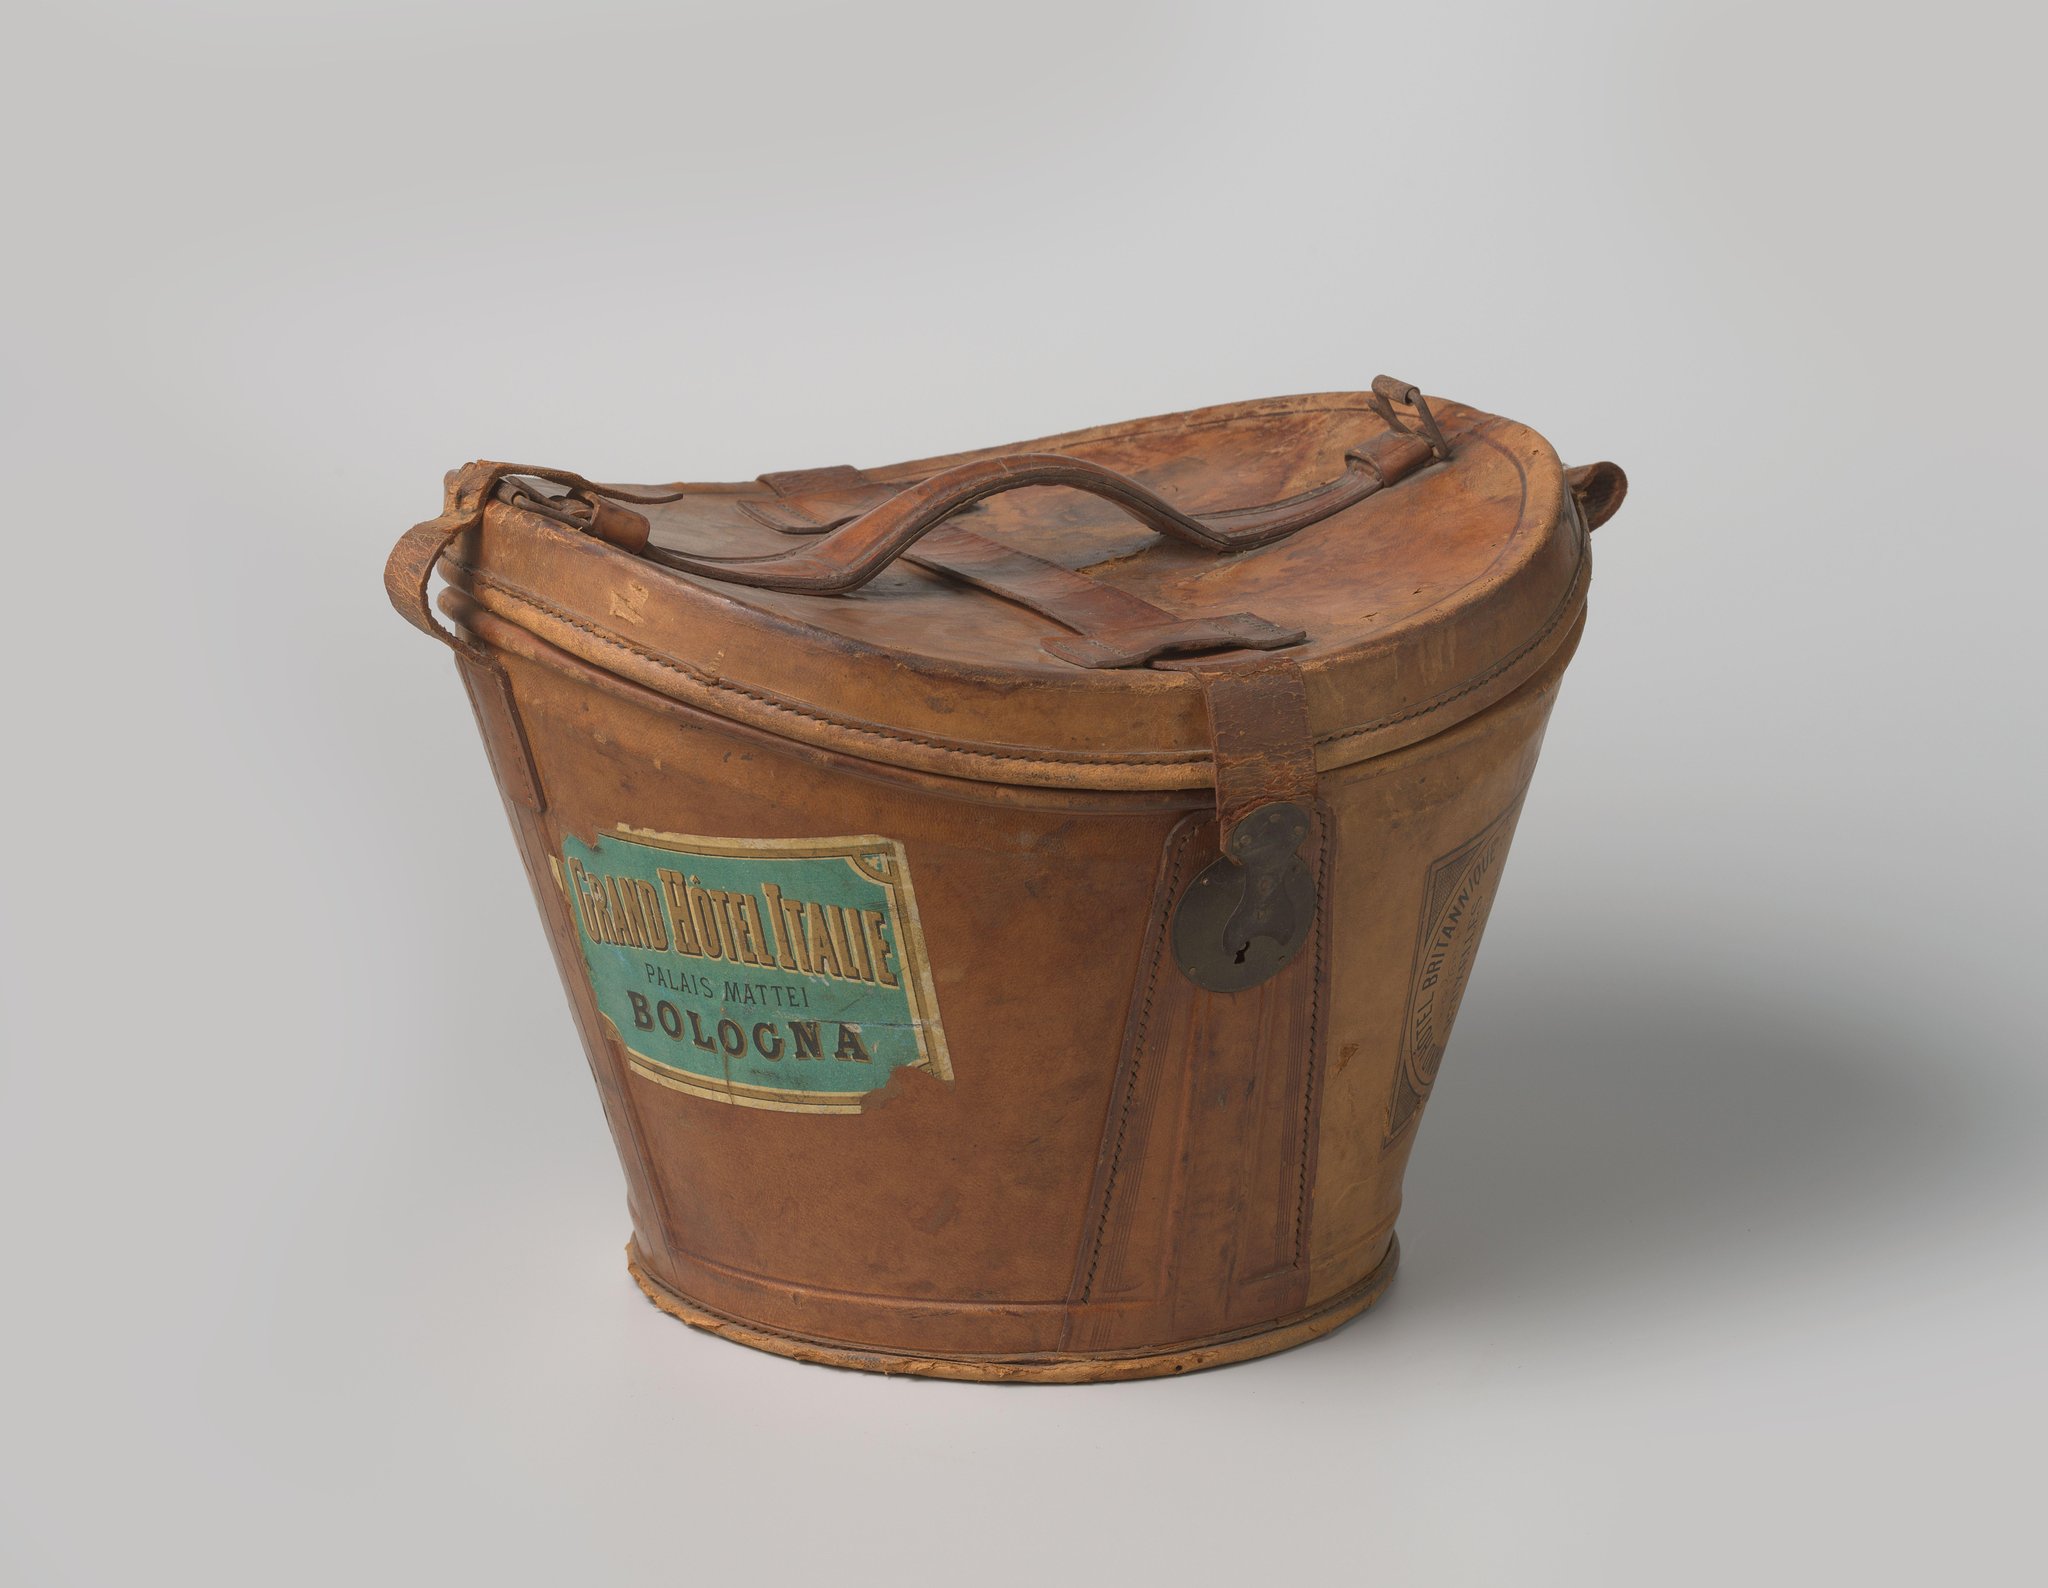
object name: clothing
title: Ovale hoedenkoffer met deksel, van bruin leer, beplakt met stickers van buitenlandse hotels; de binnenvoering is van gevuld crème satinet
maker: Anonymous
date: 1900-1925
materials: copper, leather, paper, textile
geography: western europe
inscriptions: label: ‘GRAND HÔTEL ITALIE // PALAIS MATTEI // BOLOGNA’, label: ‘GRAND HÔTEL BRITANNIQUE ACHILLE CASTREUIL// BRUXELLES // 3, Place du Trône, 3 // propriétaire’, label: ‘GARBRECHT's // GRAND HÔTEL // PISA’, label, label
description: Ovale hoedenkoffer van bruin leer. Het deksel, met handvat, is aan de koffer bevestigd met een leren riem, die aan de voorzijde te bevestigen is aan een koperen slot. Op het deksel zijn twee riemen bevestigd, die vast te maken zijn met gespen. Op de koffer zijn vijf etiketten geplakt van buitenlandse hotels. De rand van de koffer is beplakt met rood papier; de binnenzijde is verder bekleed met crème satinet.